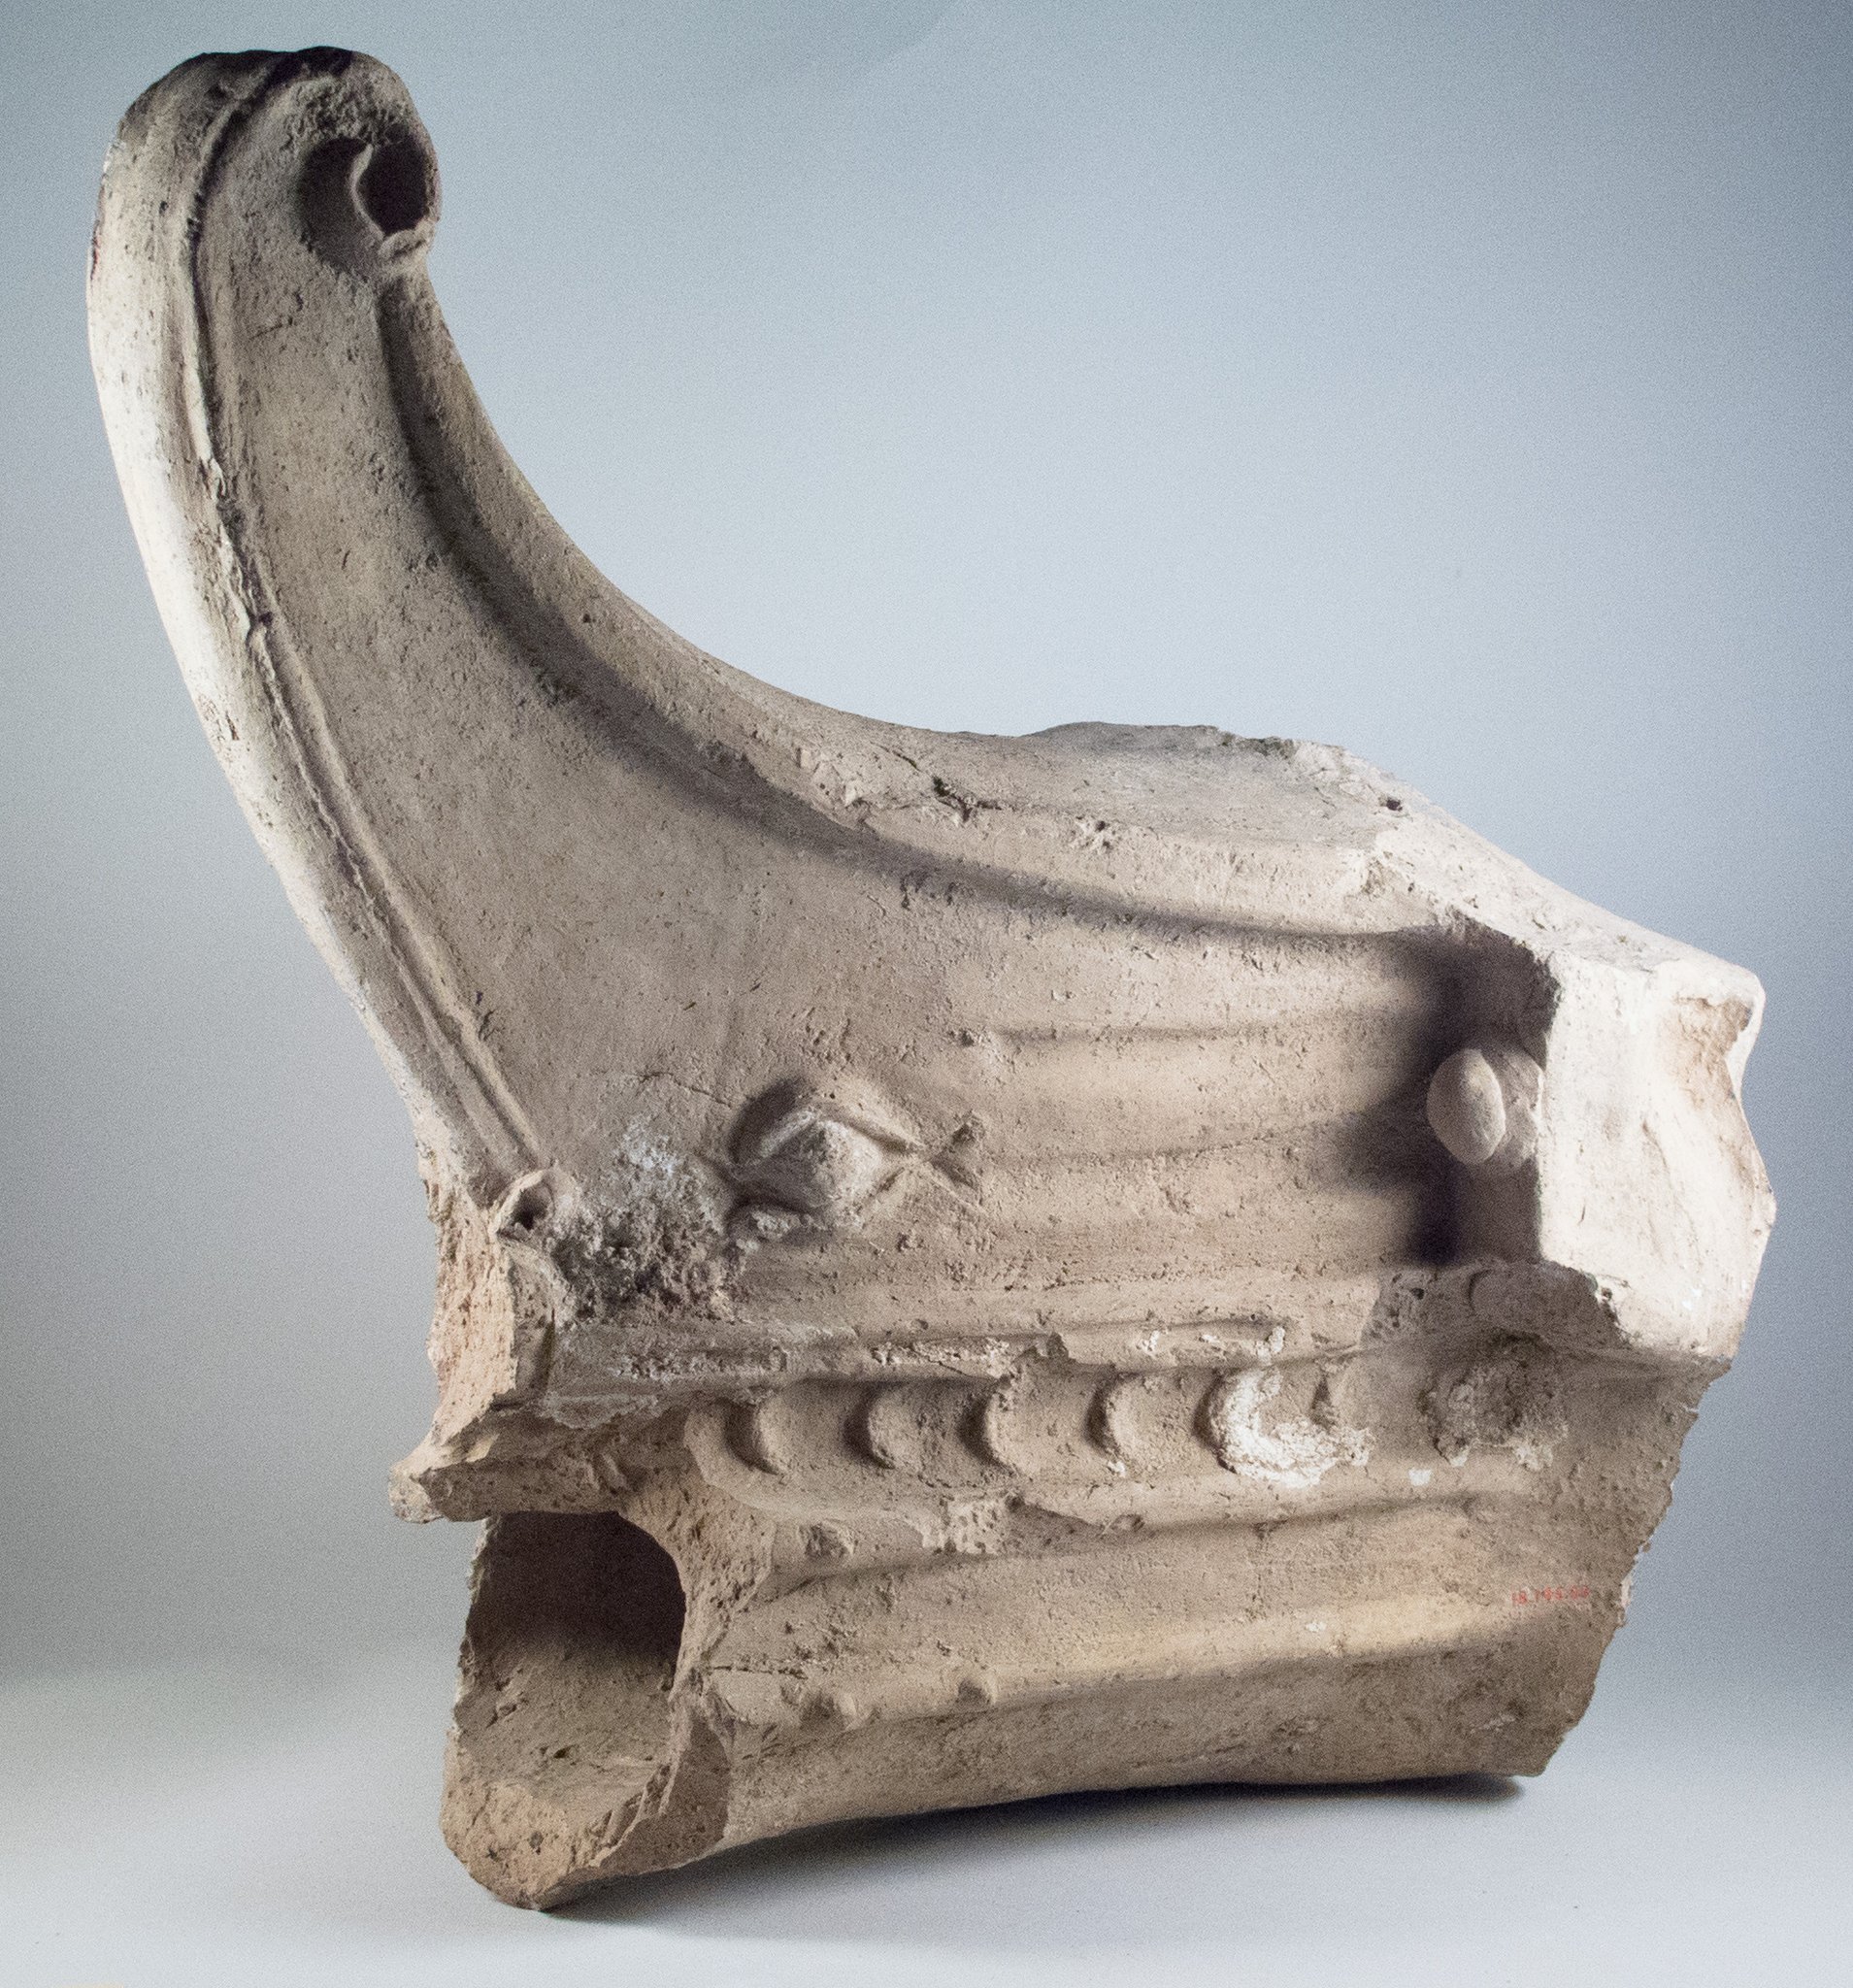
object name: rostrum with eye on each side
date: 7000 BCE-330 CE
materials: terracotta